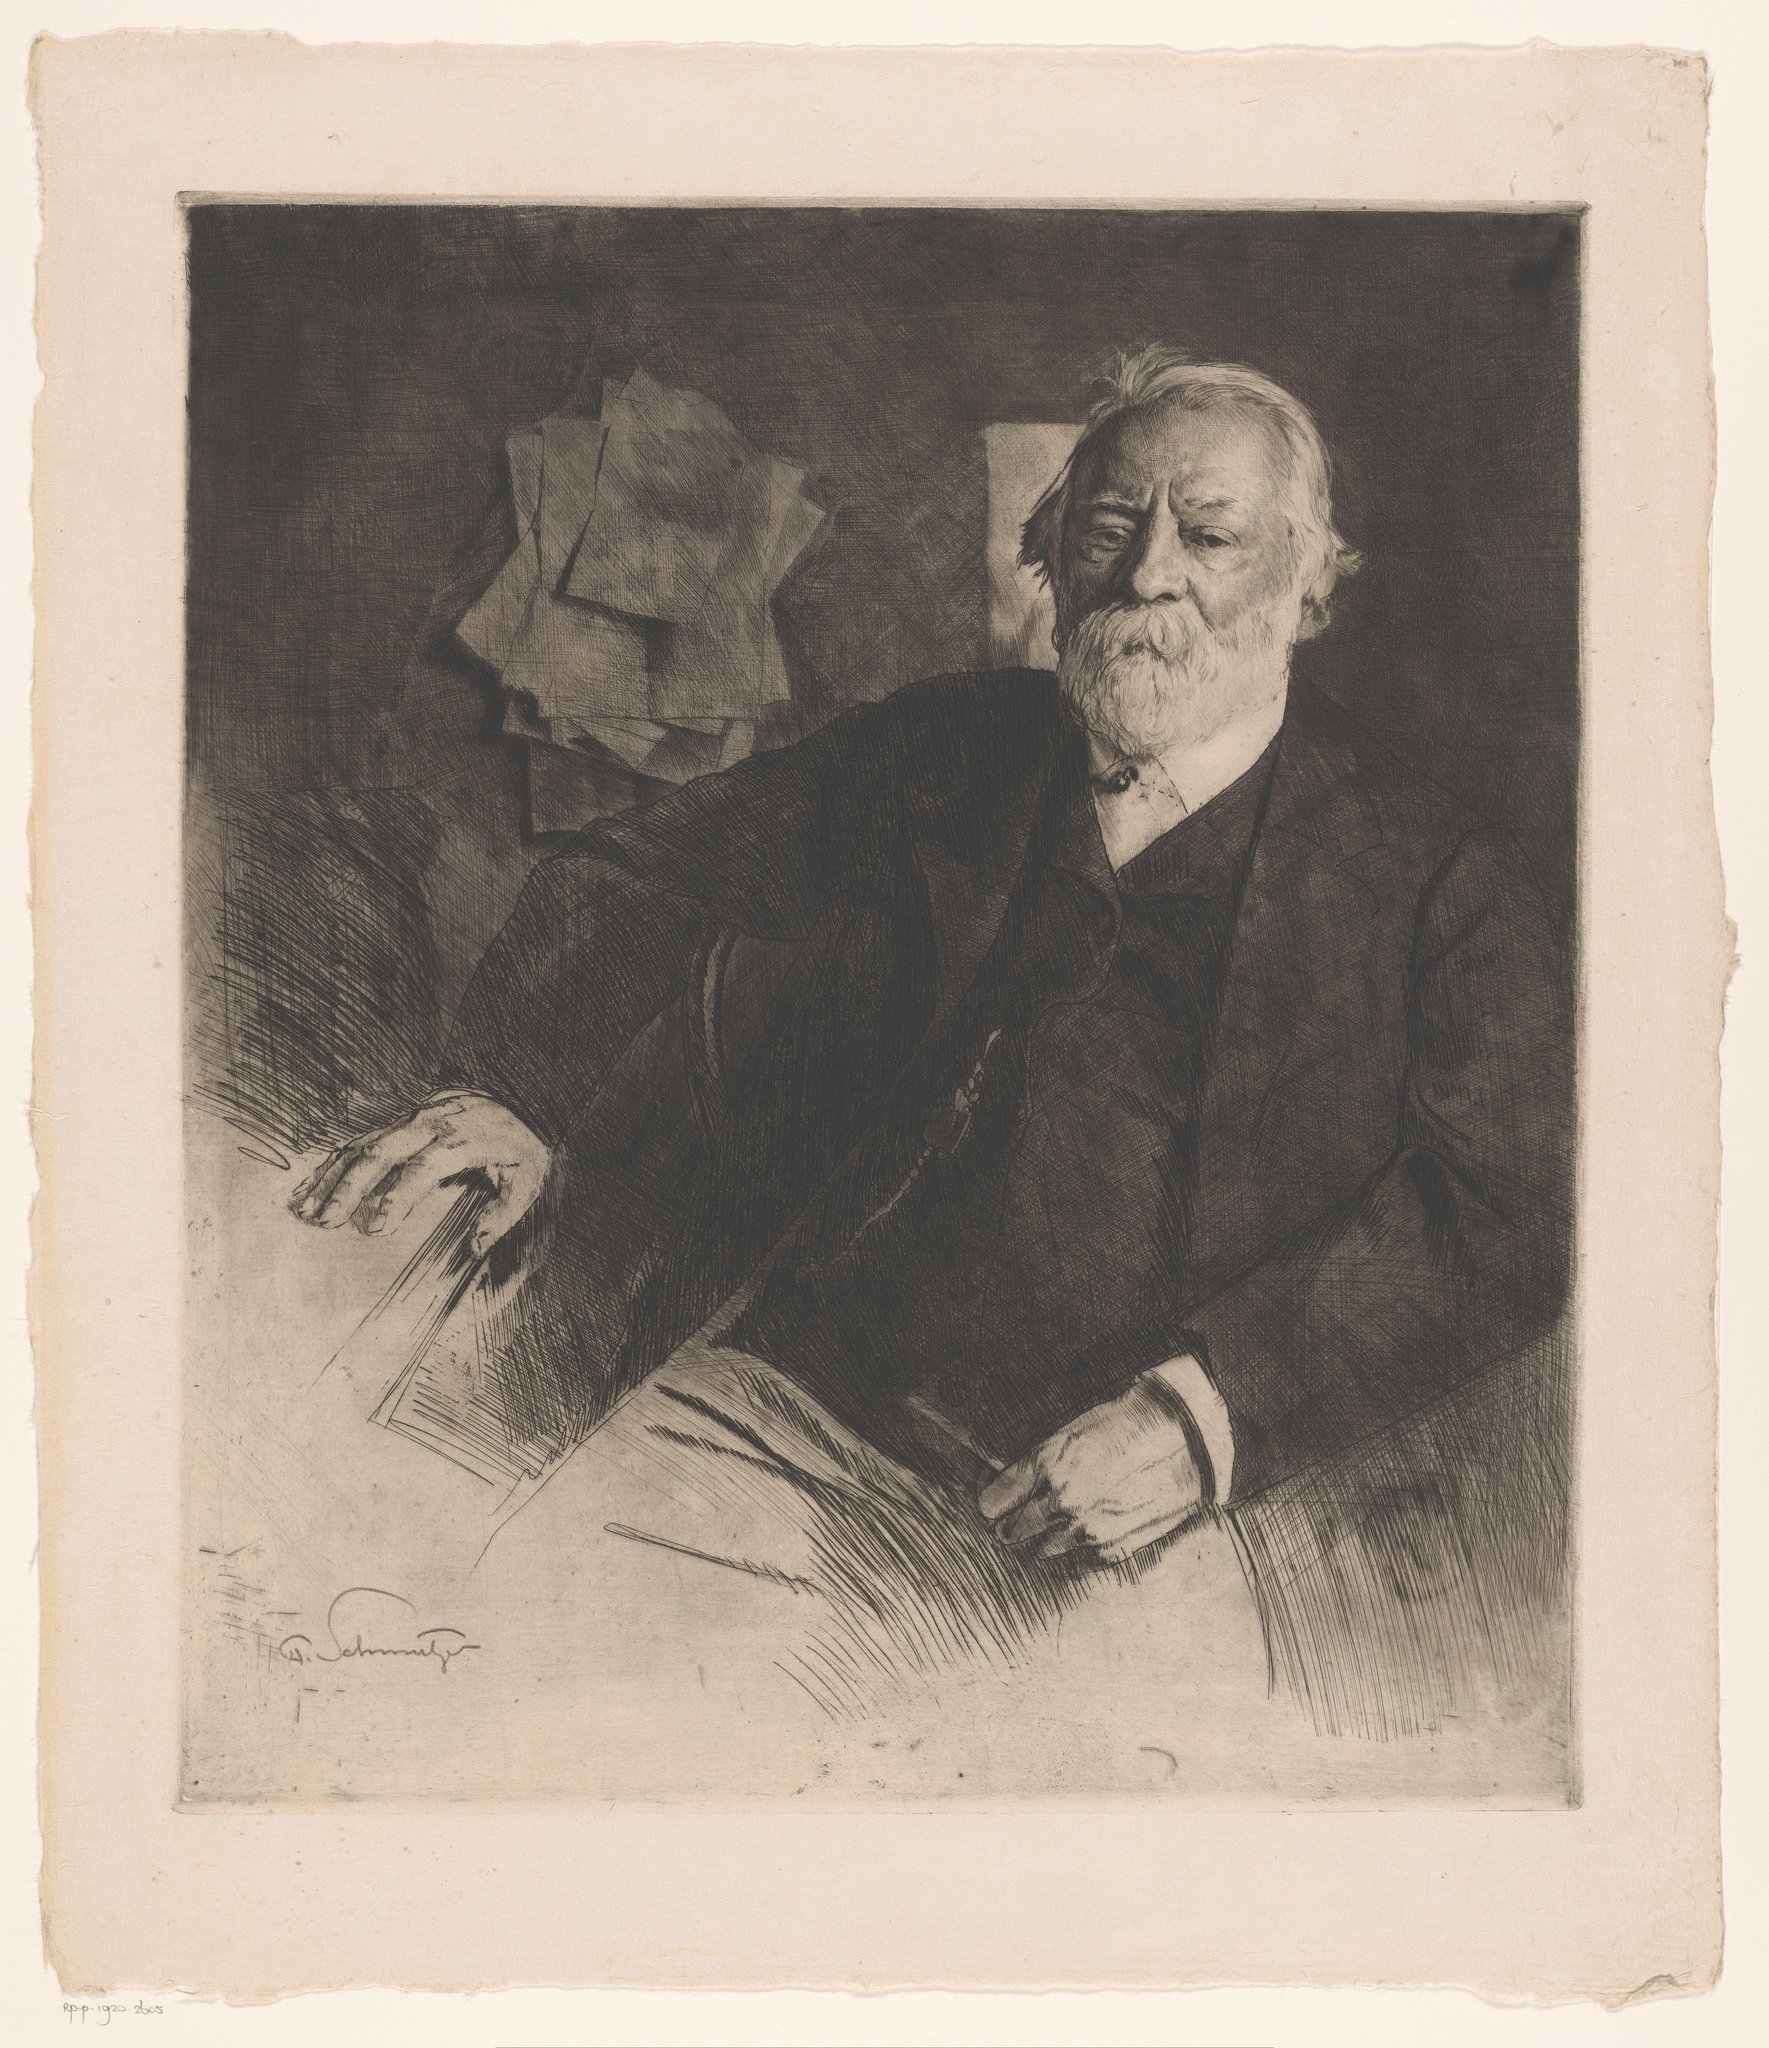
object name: print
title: Portret van Theodor Leschetizky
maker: ferdinand schmutzer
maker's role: painter, print maker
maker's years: 1870-1928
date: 1880-1920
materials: paper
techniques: drypoint, etching, intaglio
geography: vienna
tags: portrait of a musician, portrait of composer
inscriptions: collector's mark: Lugt 2228